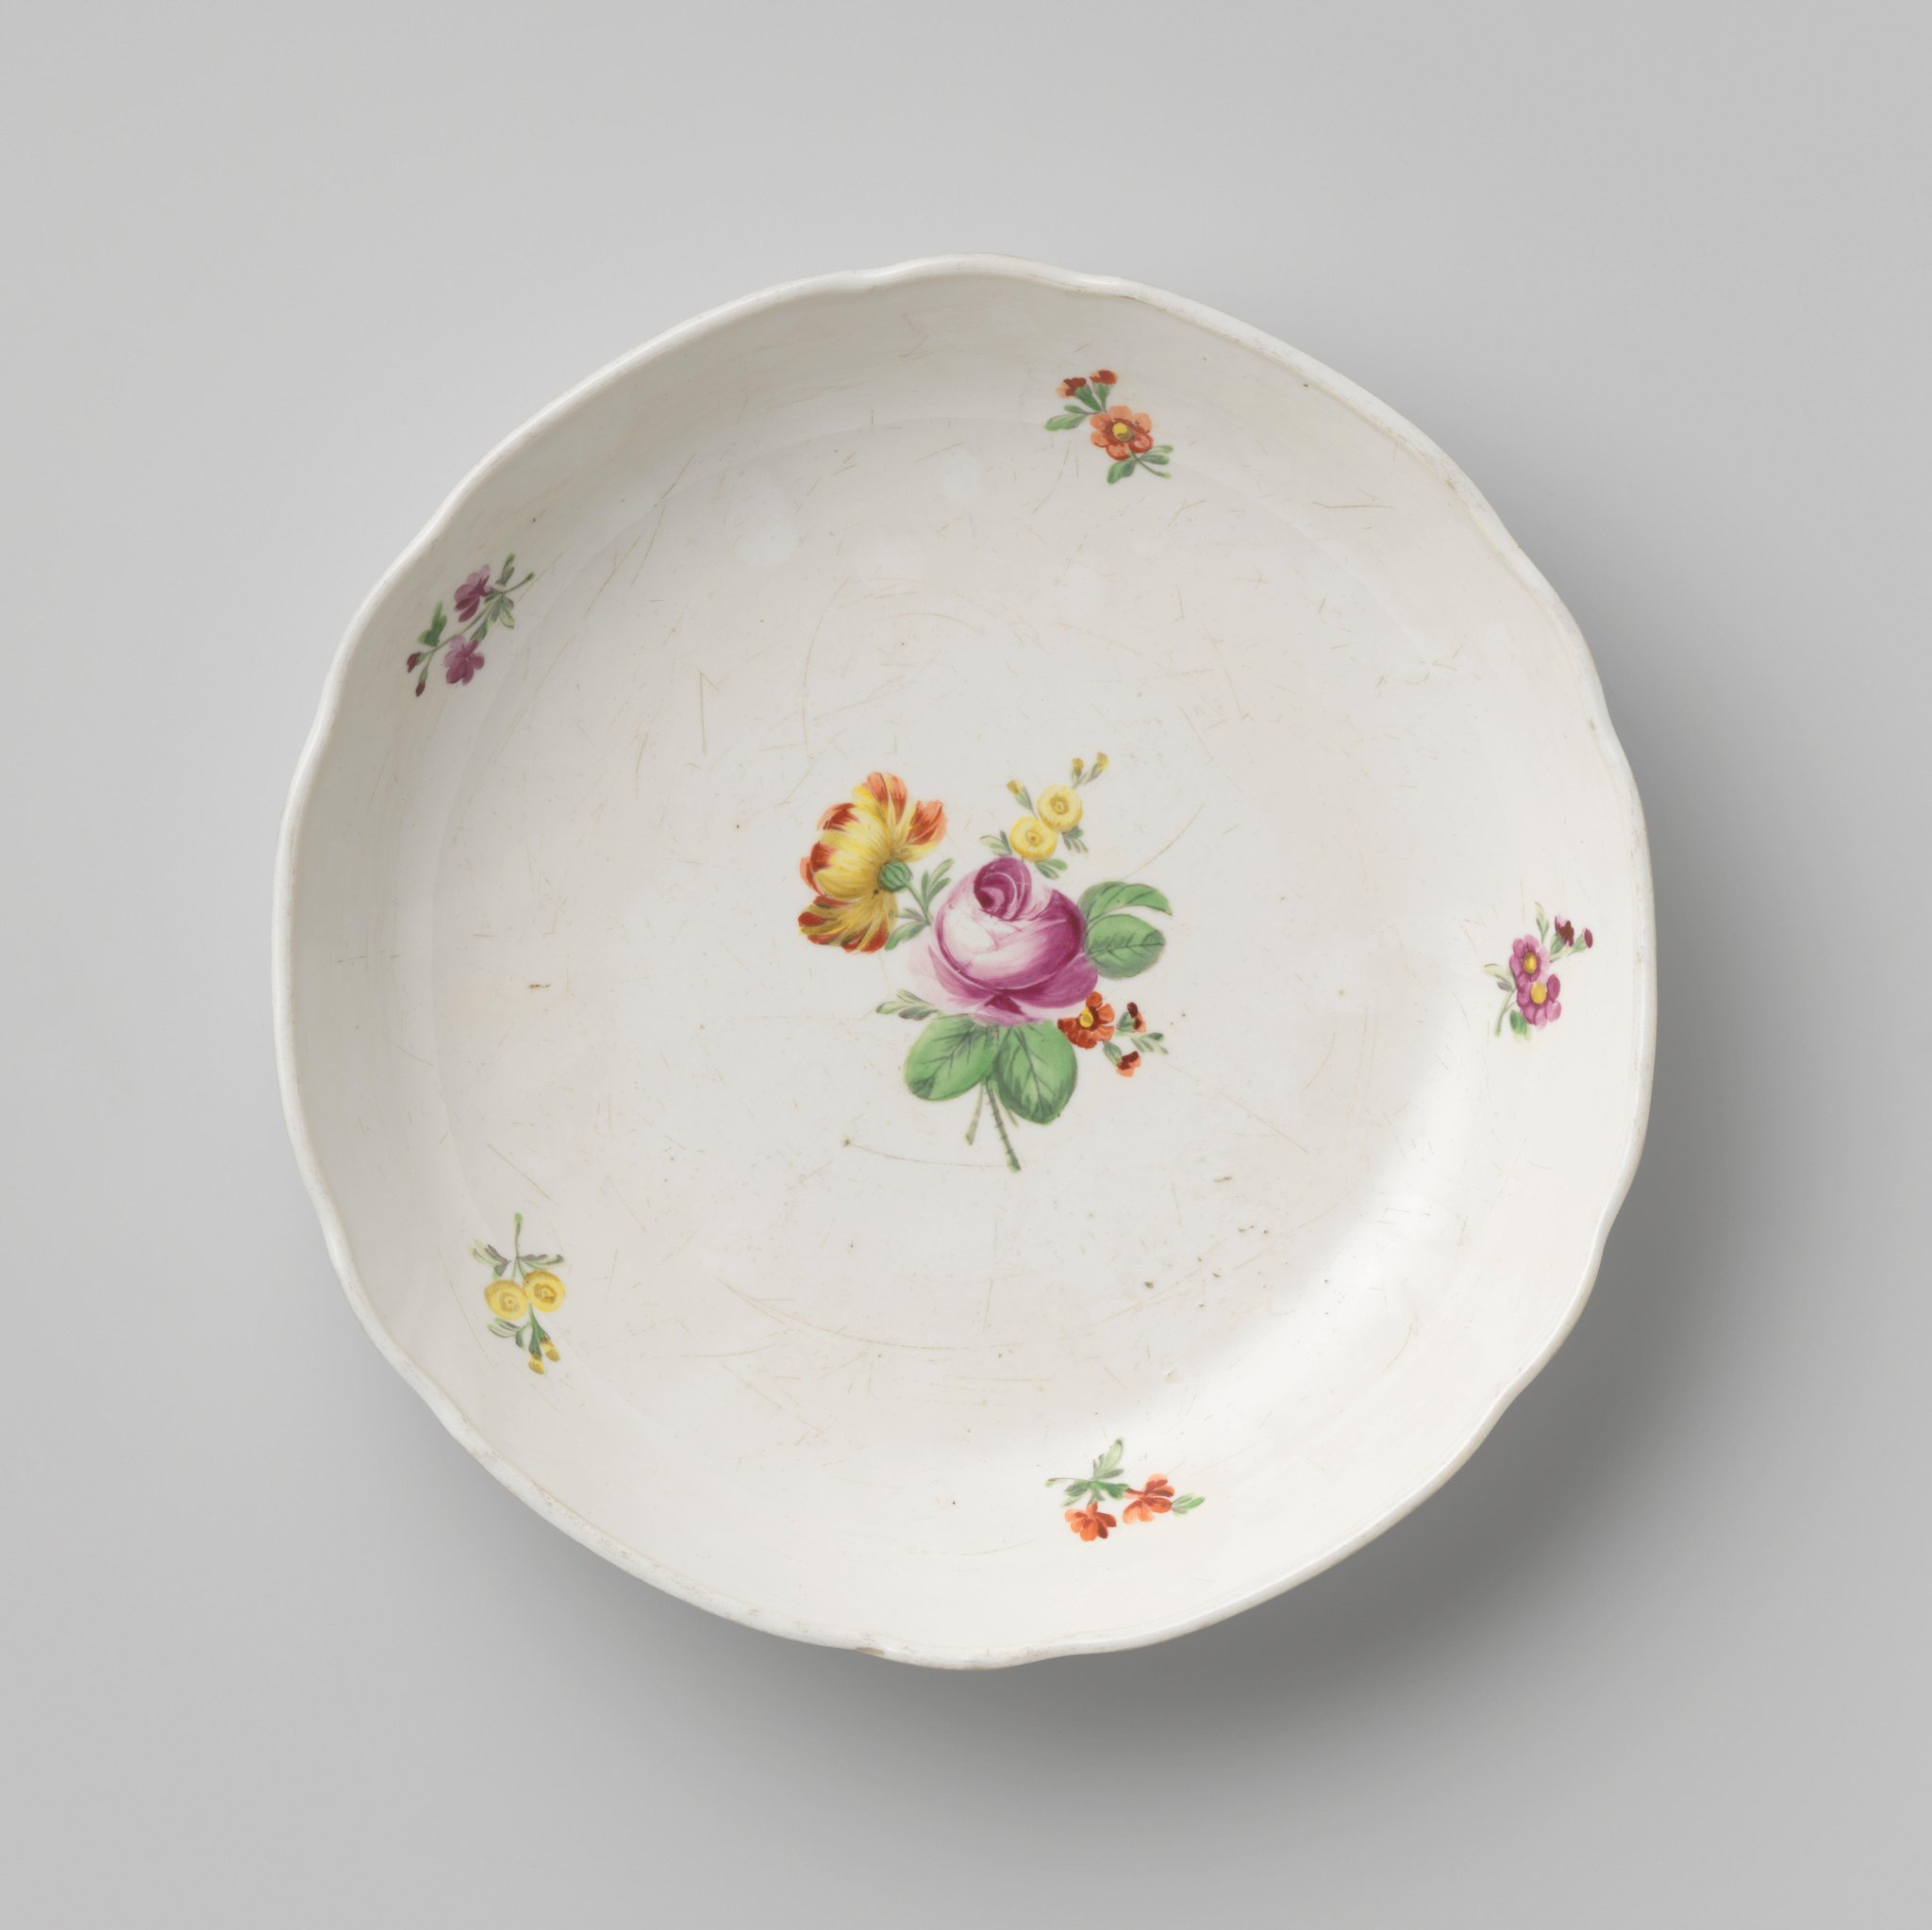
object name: dish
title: Dish with a bouquet and flower sprays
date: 1800-1849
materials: glaze, paint, porcelain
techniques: firing, forming, turning, vitrification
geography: vienna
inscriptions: mark: ‘schild/ P85/ 11/ 91’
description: Schaal van porselein met gelobde rand, beschilderd op het glazuur in rood, roze, groen, geel en paars. Op het plat een boeket van verschillende bloemen (o.a. pioenroos) en op de binnenwand vijf bloemtakken. Gemerkt op de onderzijde met het schild, P85 en de nummers 11 en 91.